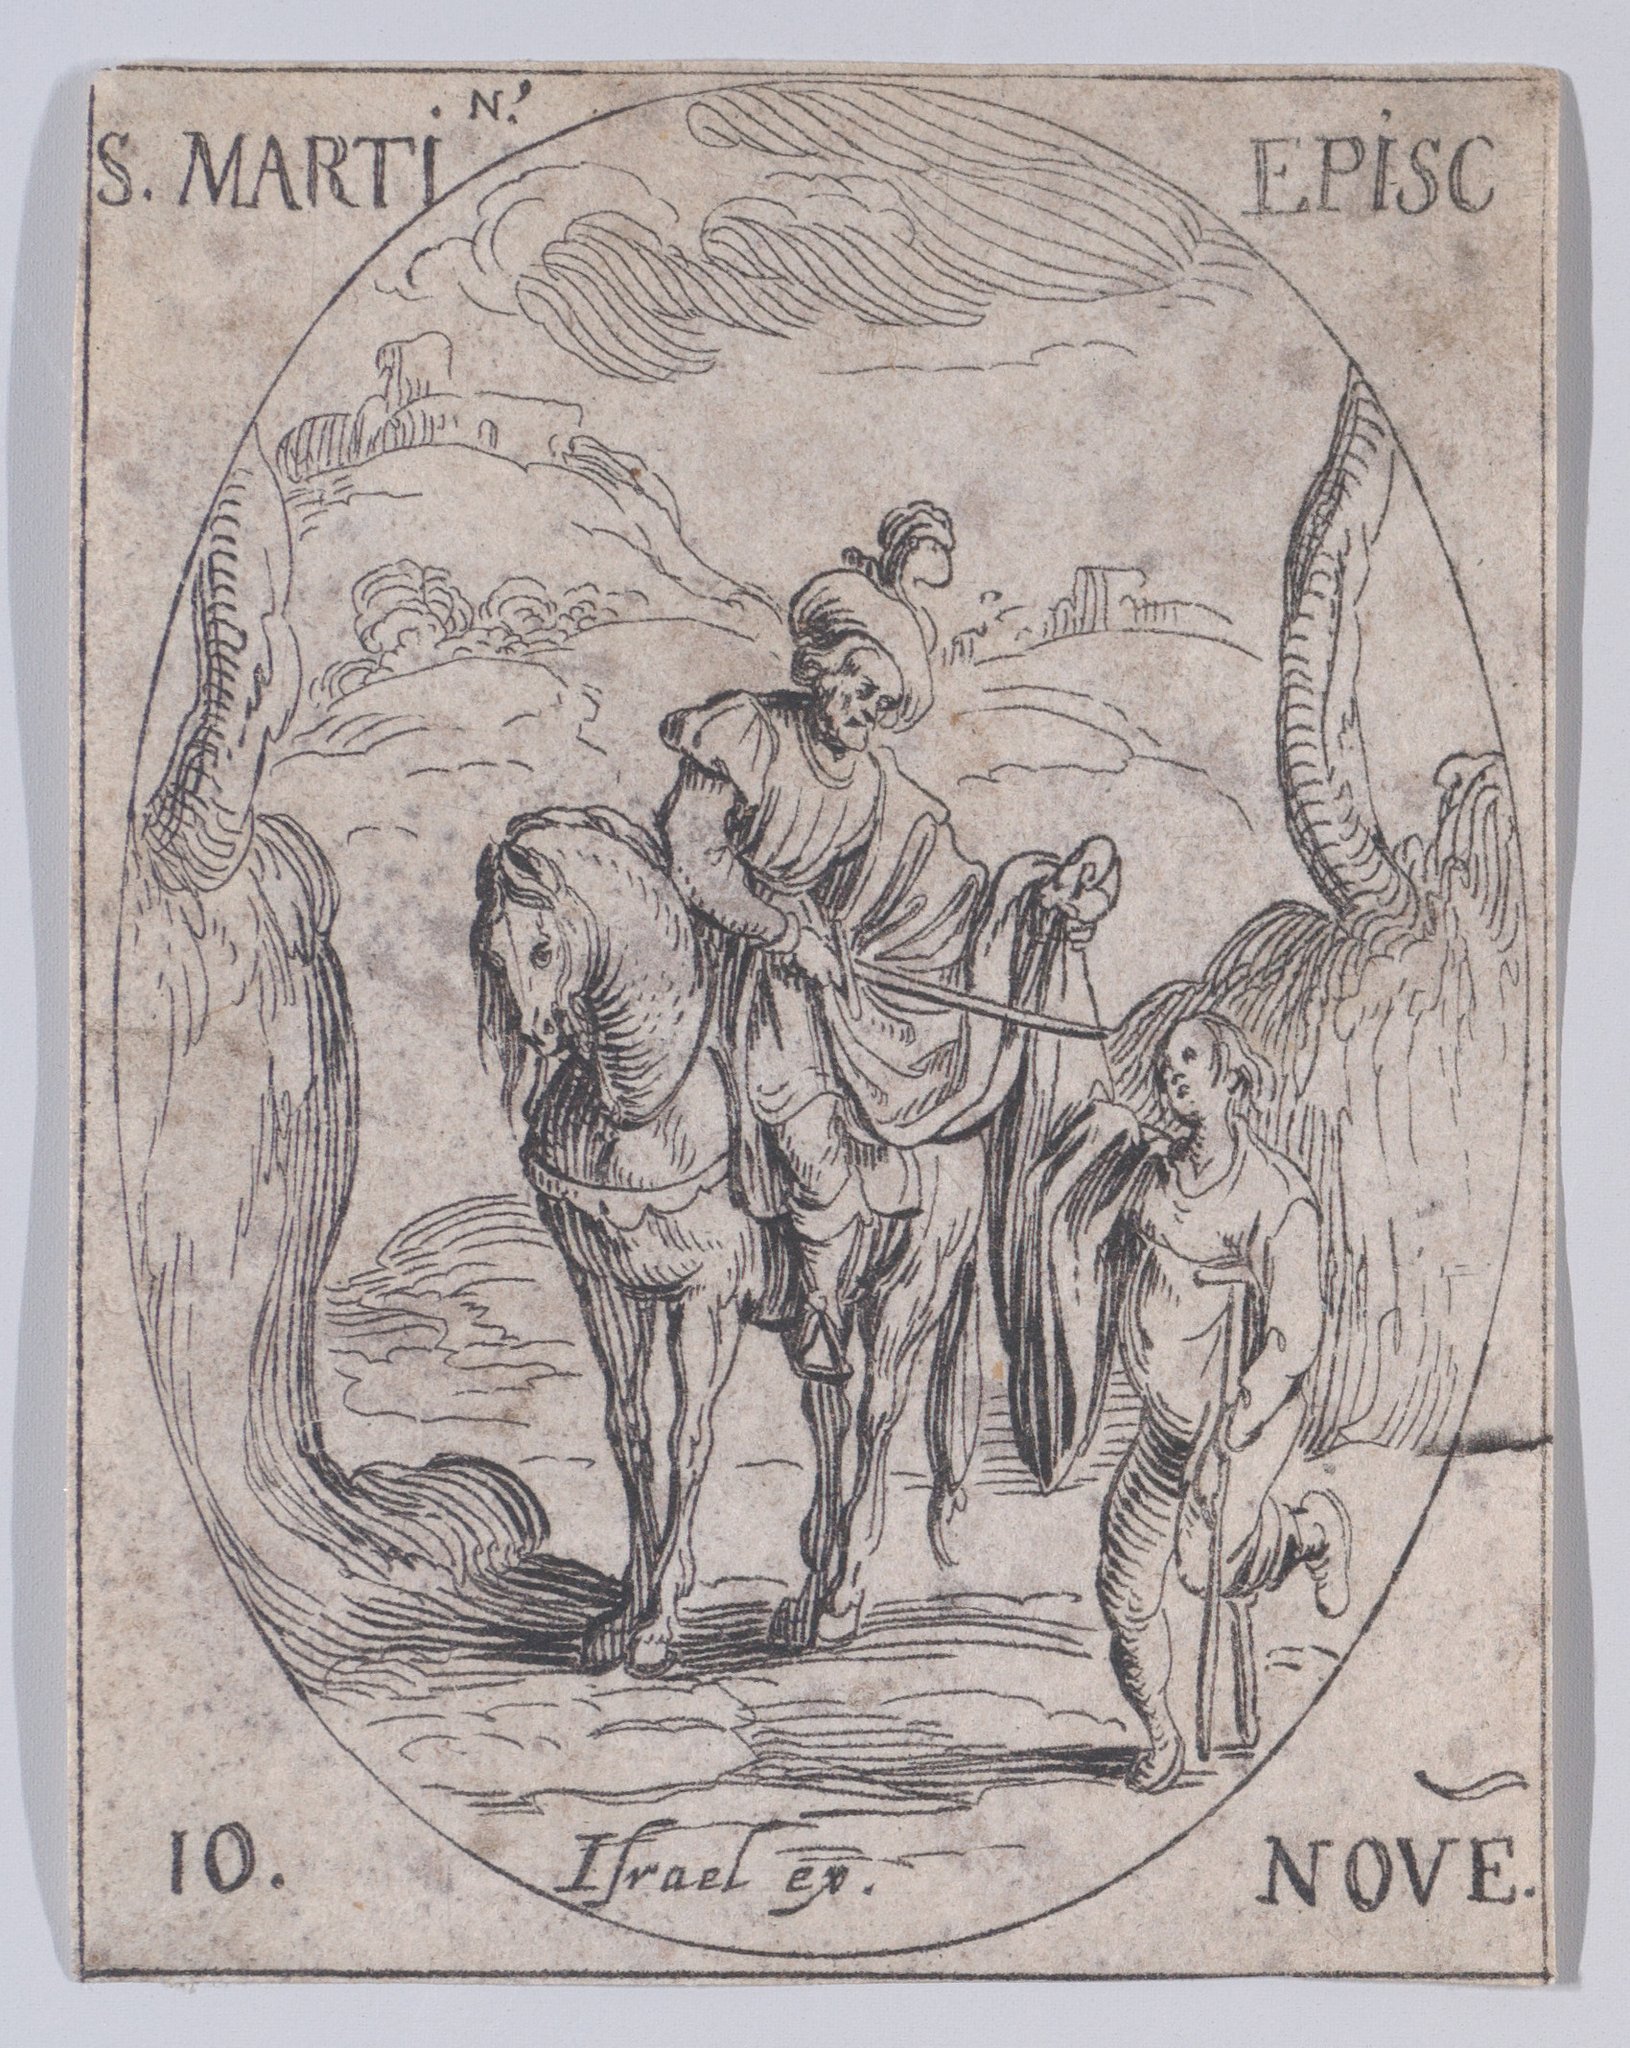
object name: print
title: S. Martin, évêque (St. Martin, Bishop), November 10th, from "Les Images De Tous Les Saincts et Saintes de L'Année" (Images of All of the Saints and Religious Events of the Year)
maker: jacques callot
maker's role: artist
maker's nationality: french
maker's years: 1592-1635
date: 1636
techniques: etching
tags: men,horses,saints